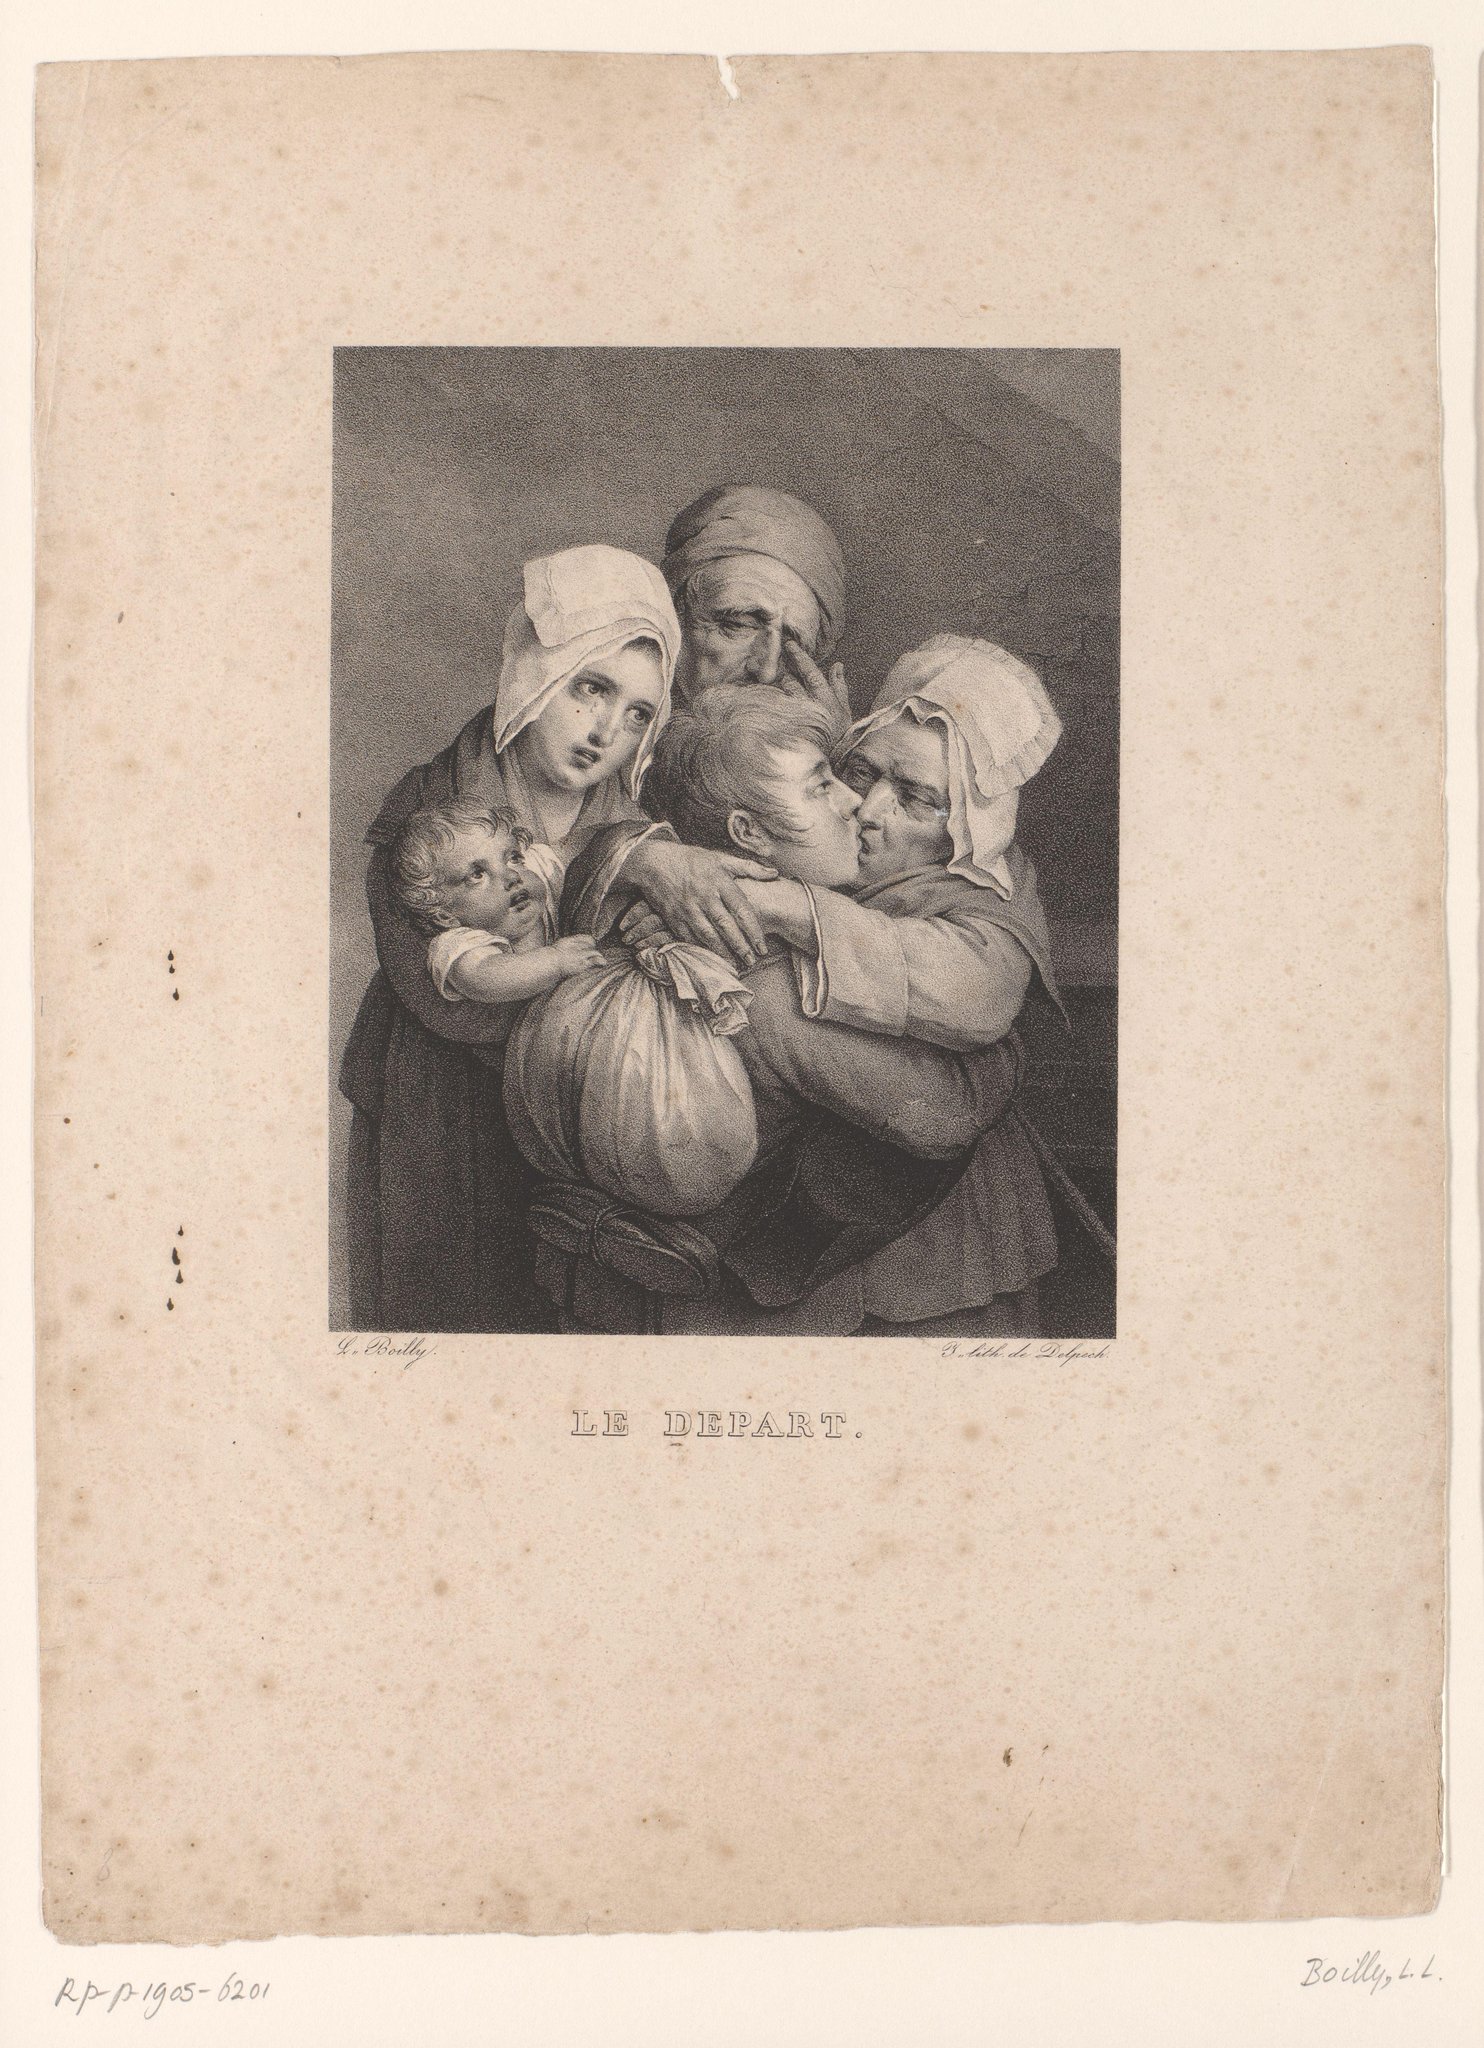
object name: print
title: Le depart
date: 1825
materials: paper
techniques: lithograph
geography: paris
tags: soldier(s) before enlisting, child(ren) with one or both parents and one or more members of the preceding generation (family group), taking leave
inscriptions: collector's mark: Lugt 2228a